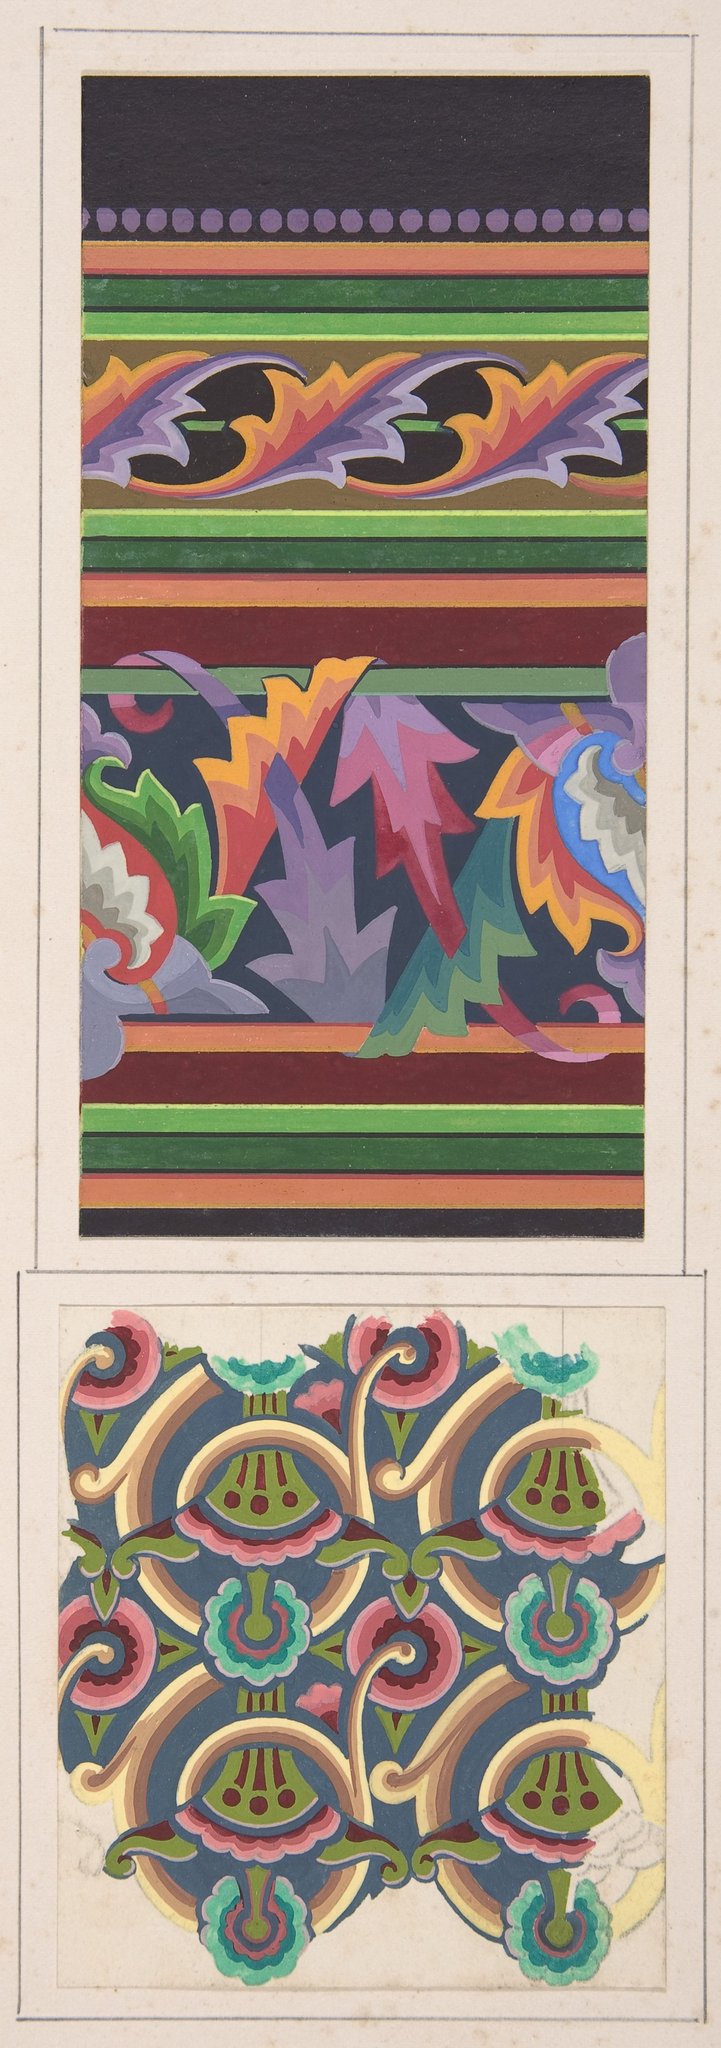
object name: drawing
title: Design drawing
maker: christopher dresser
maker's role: designer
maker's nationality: british, scottish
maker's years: 1834-1904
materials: gouache, graphite, ink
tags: ornament